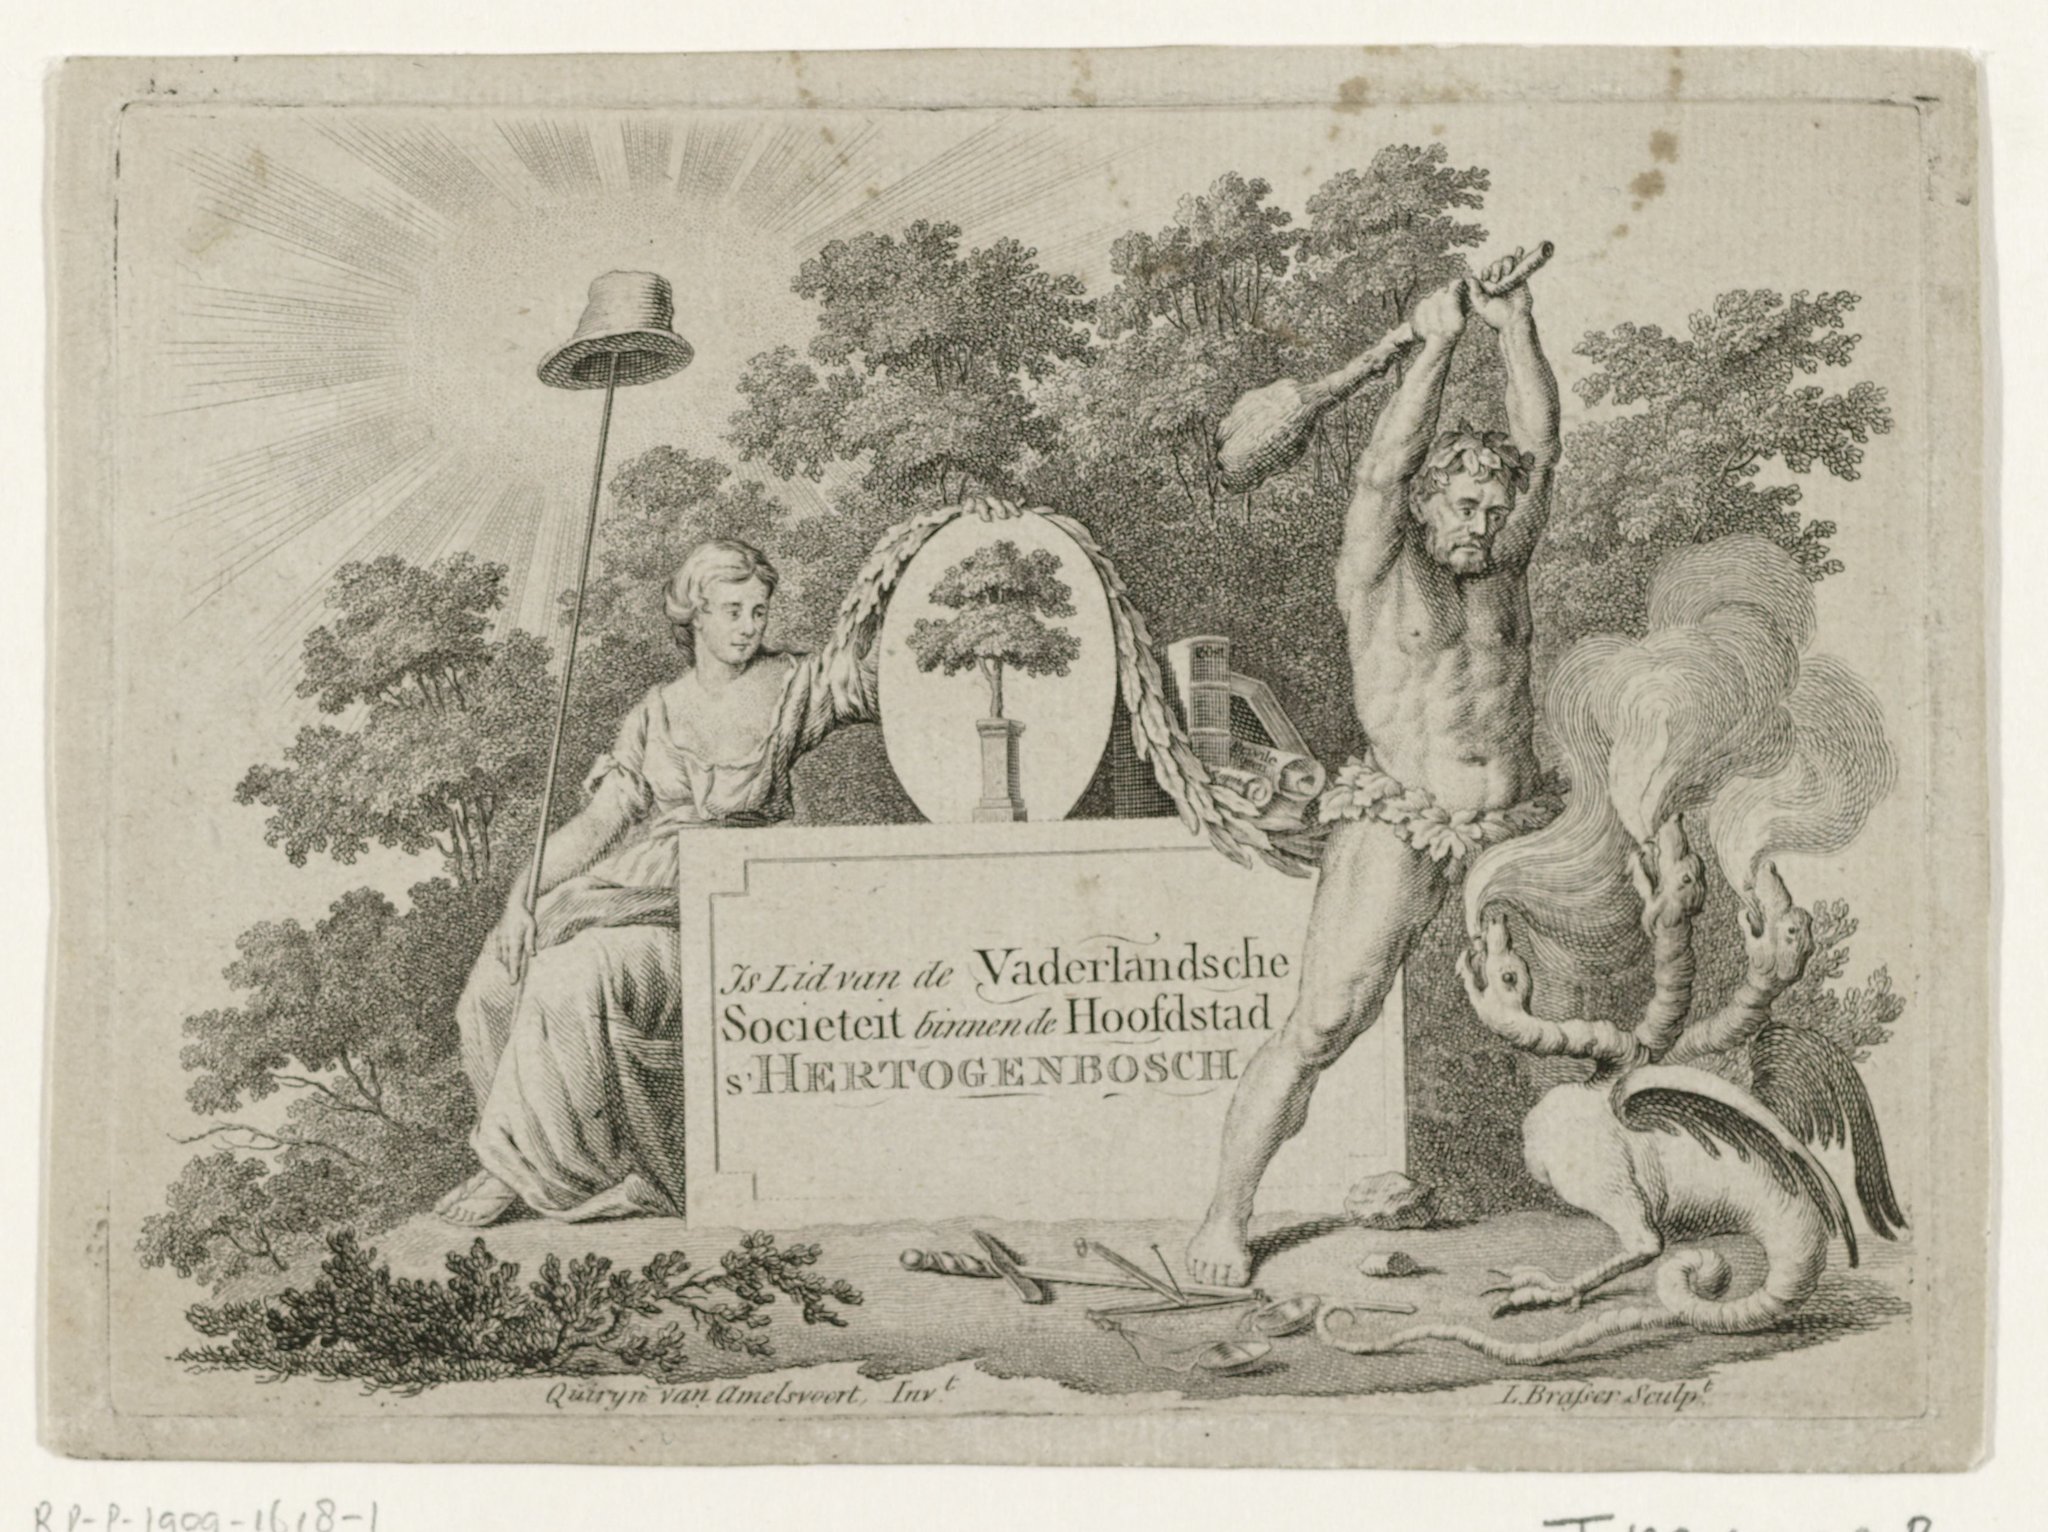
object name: membership certificate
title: Lidmaatschapskaart van de Vaderlandsche Sociëteit te 's-Hertogenbosch, ca. 1787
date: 1787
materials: paper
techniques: engraving, etching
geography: northern netherlands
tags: (2) the hydra of lerna is killed by hercules, freedom, liberty; 'libertà' (ripa) (+ abstract concept represented by female figure), den bosch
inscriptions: collector's mark: Lugt 2228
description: Lidmaatschapskaart van de Vaderlandsche Sociëteit te 's-Hertogenbosch, ca. 1787. Kaart waarop de naam van het lid niet is ingevuld. Met allegorische voorstelling waarin de Vrijheid met speer en stralende vrijheidshoed toeziet hoe Hercules de Hydra verslaat.